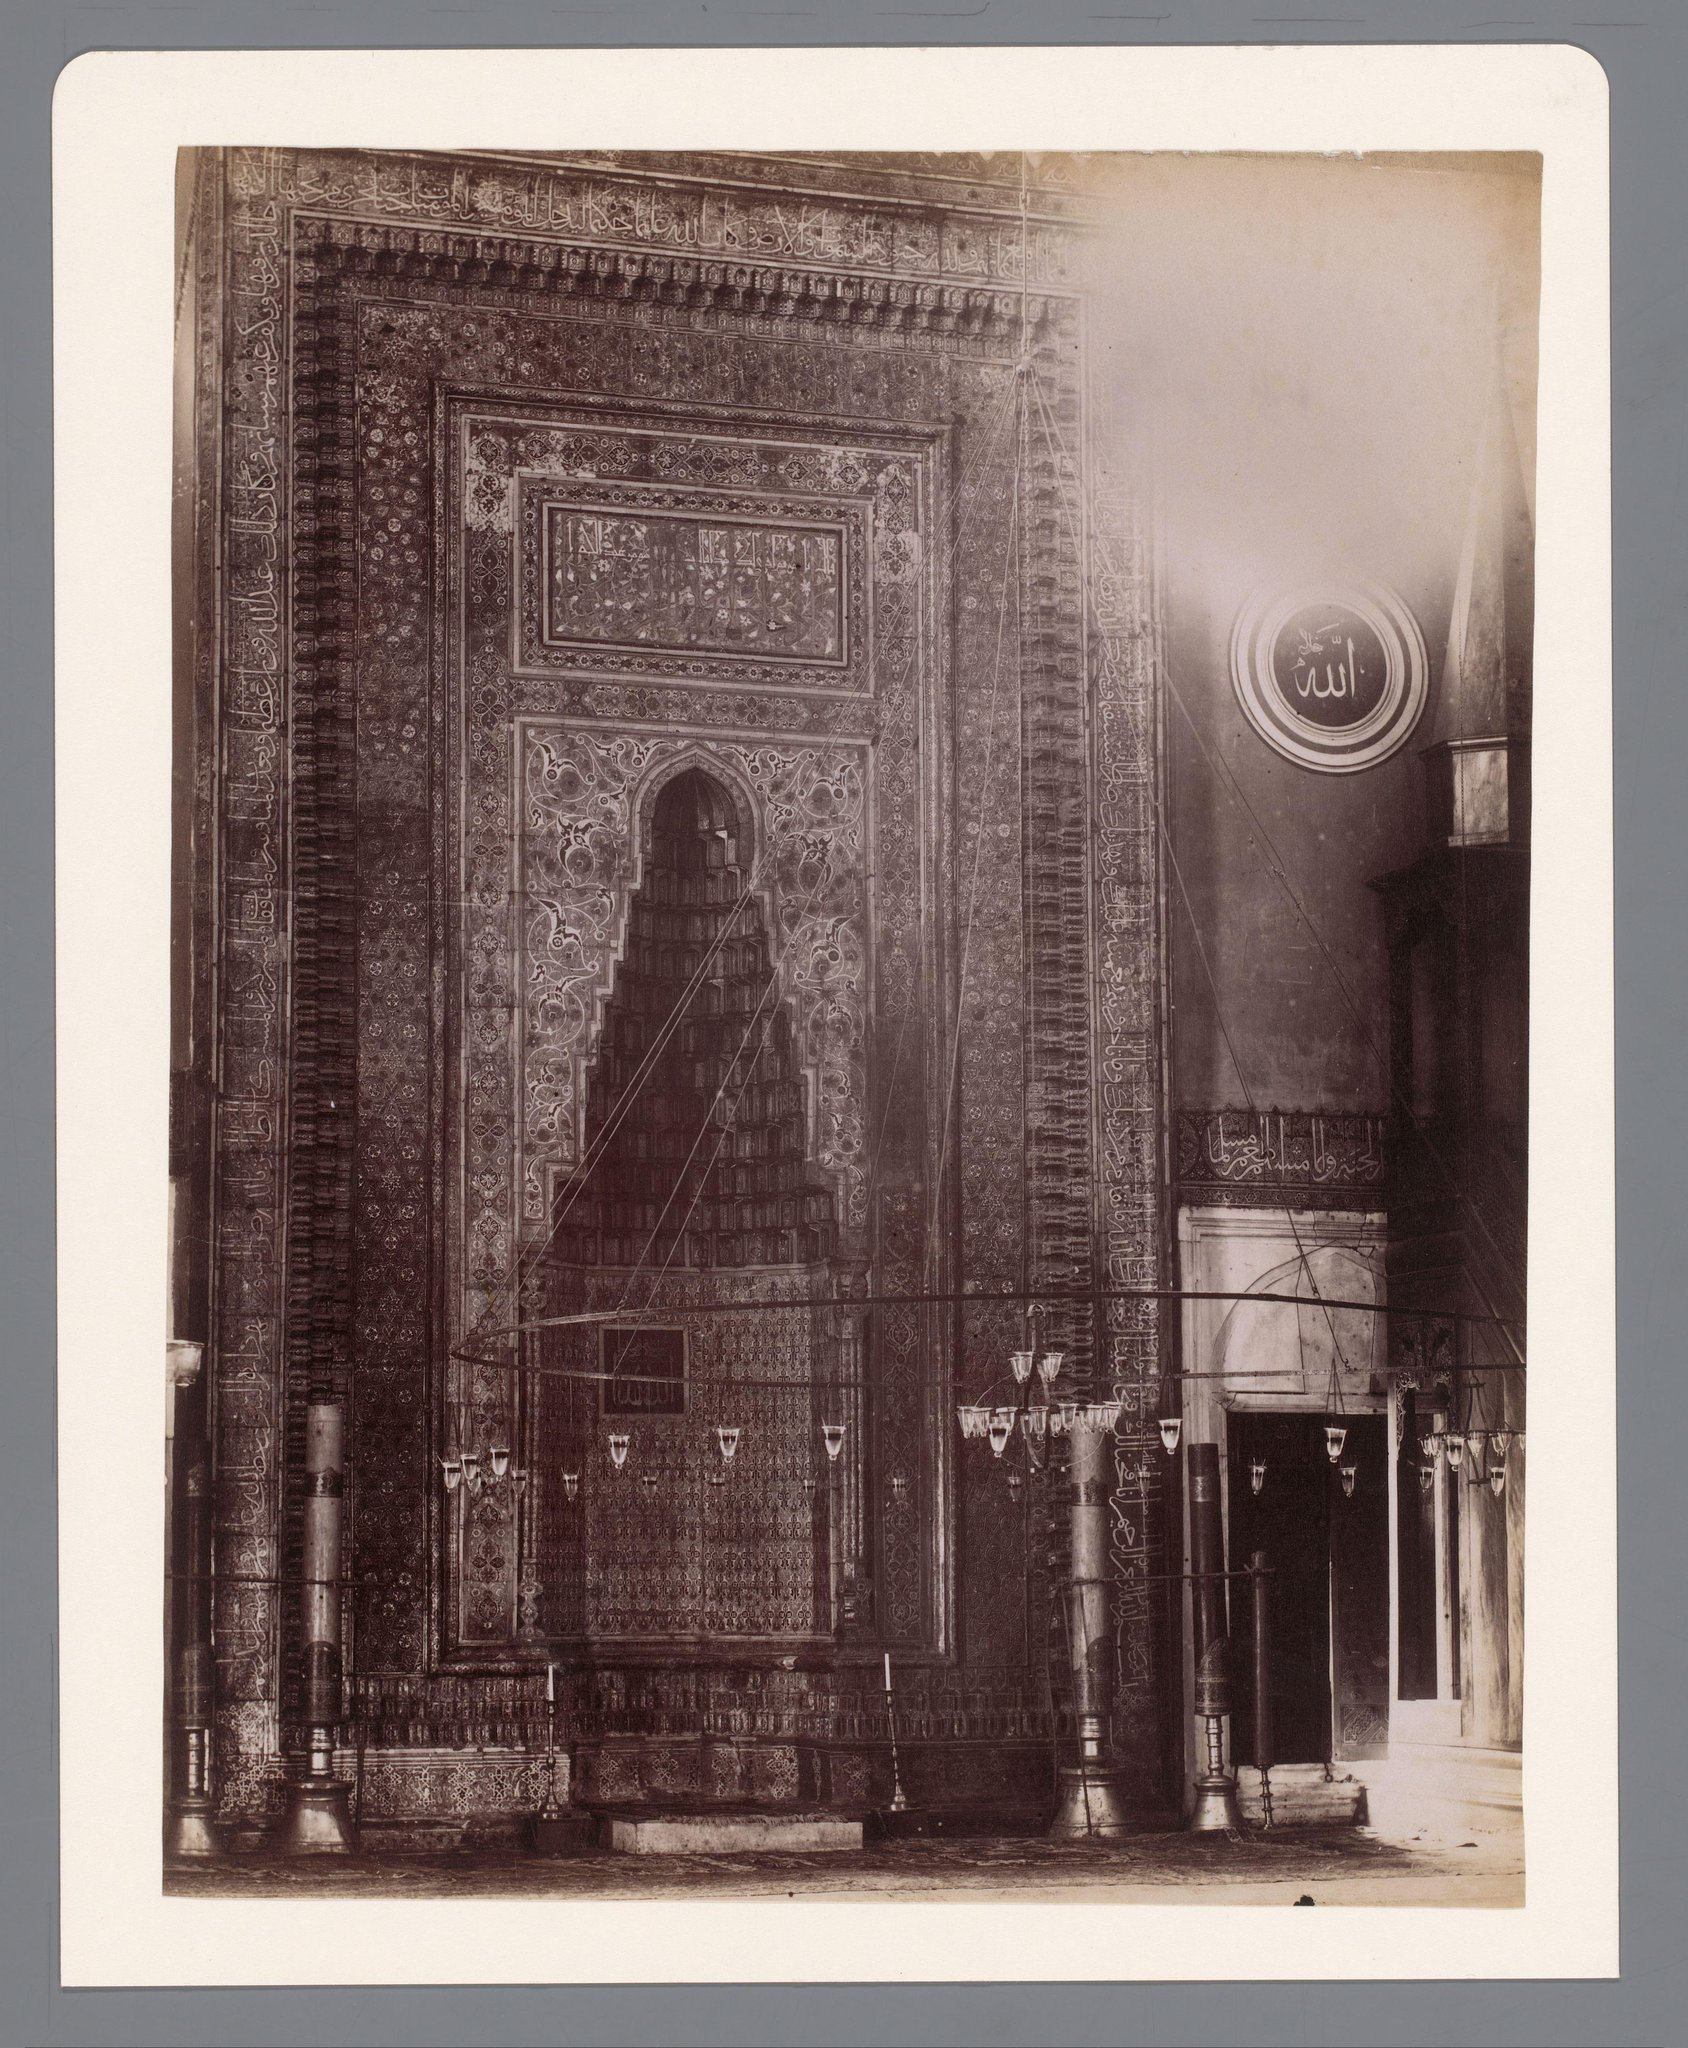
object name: photograph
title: Interieur van een moskee, mogelijk in Istanboel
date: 1888-1900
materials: paper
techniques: albumen print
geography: istanbul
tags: temple, shrine ~ islam, mohammedanism